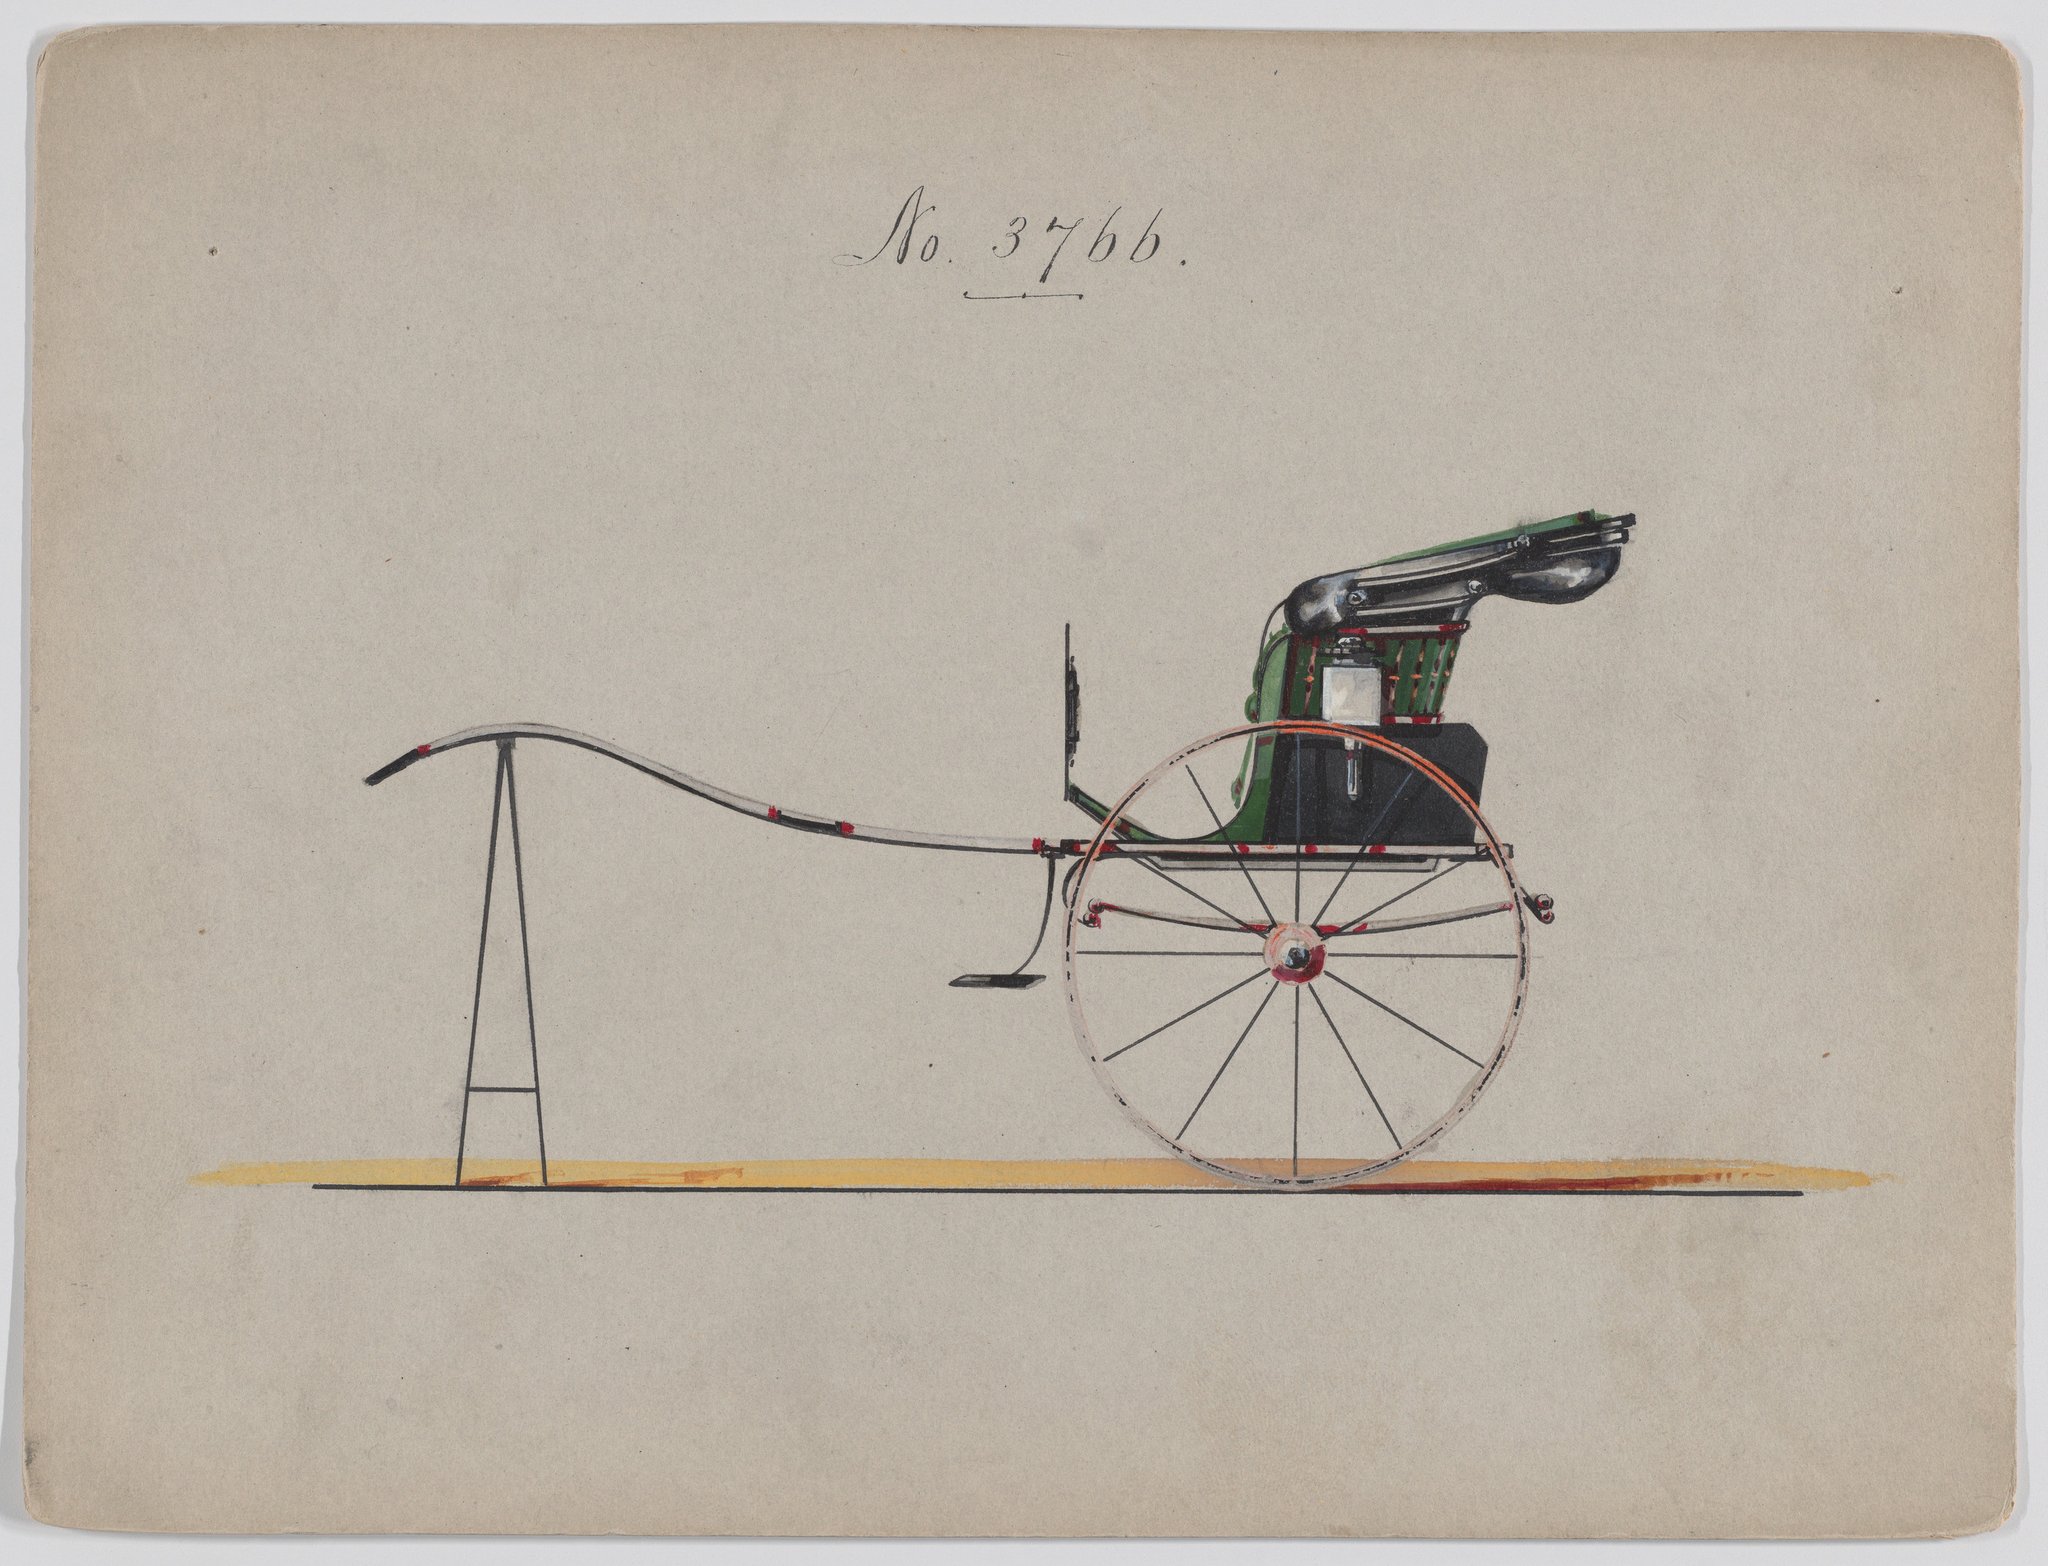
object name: drawing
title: Stanhope Gig # 3766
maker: brewster & co.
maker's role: manufacturer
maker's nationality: american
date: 1882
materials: gouache, gum arabic, ink, watercolor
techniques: pen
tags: carriages